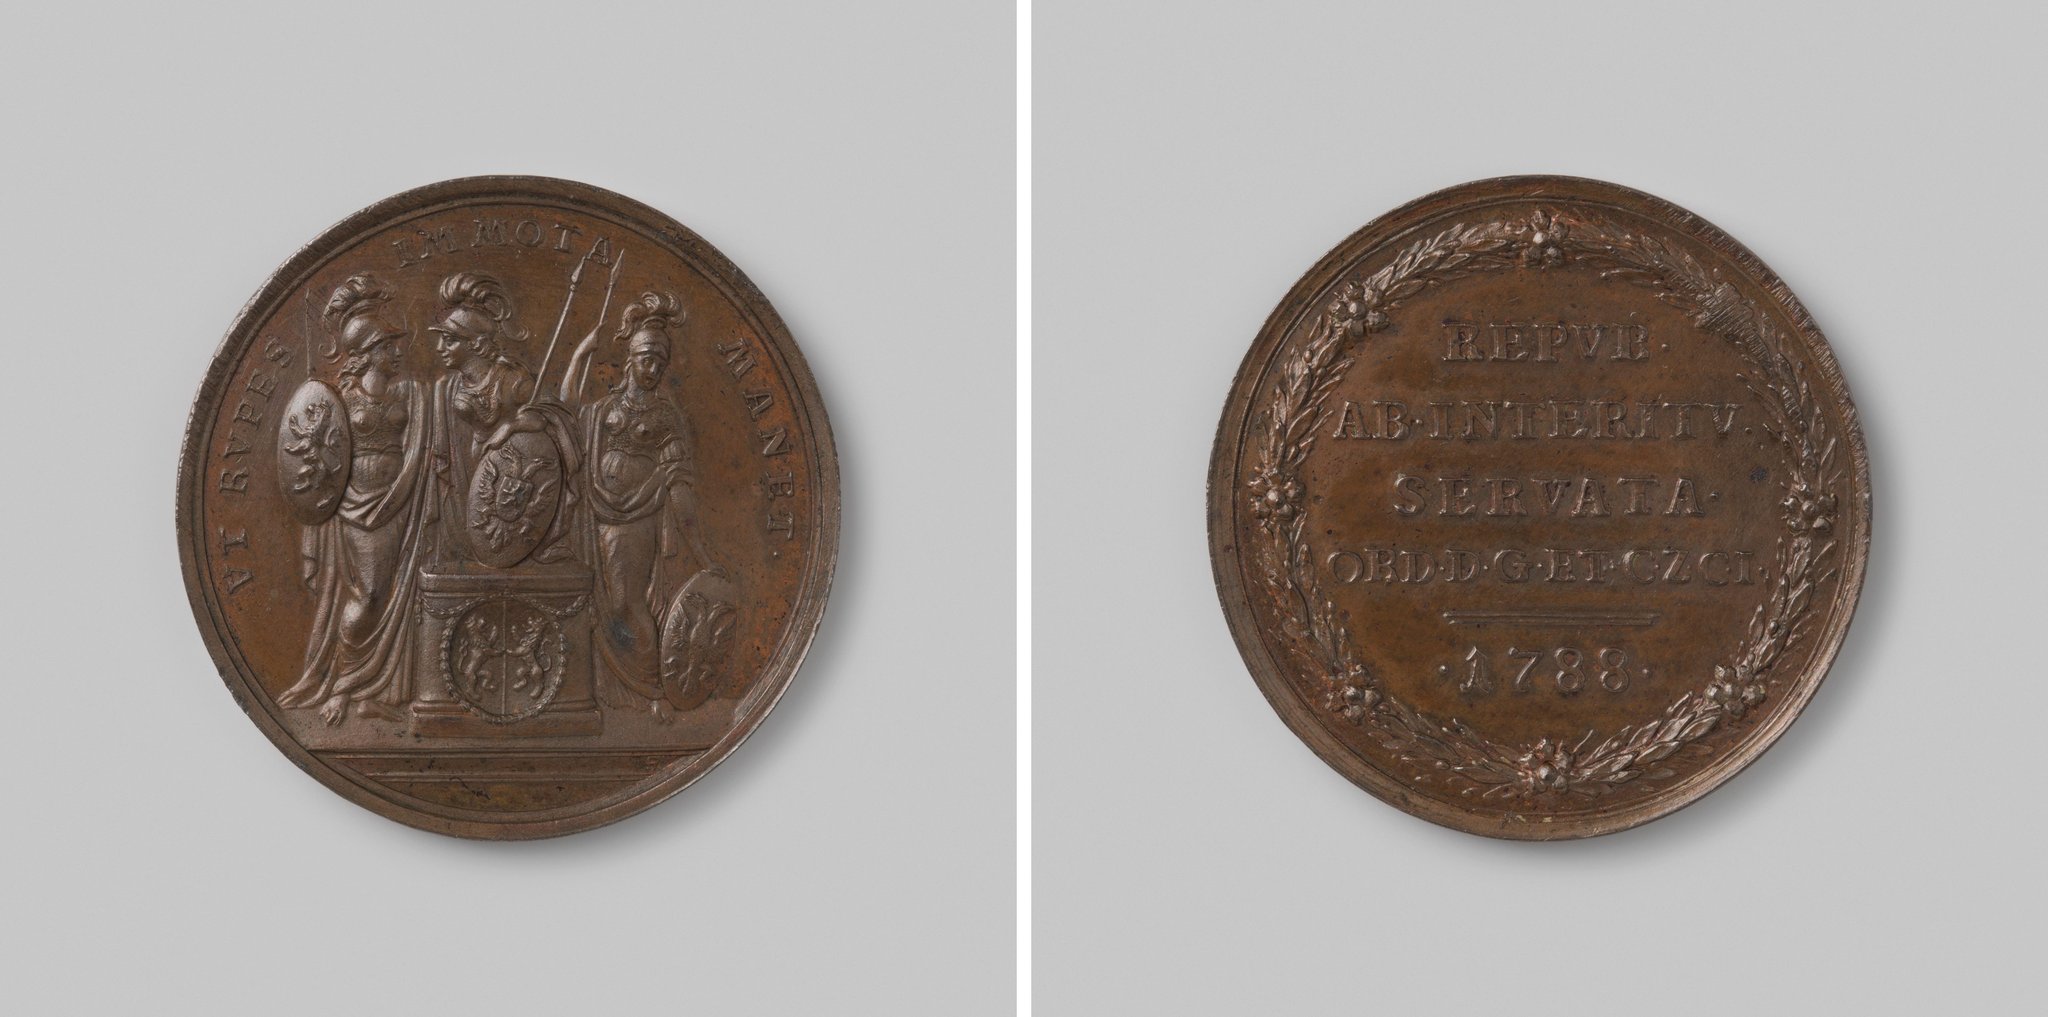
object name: history medal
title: Herstel van de orde in de Nederlanden 1788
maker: johann heinrich schepp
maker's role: sculptor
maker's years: 1736-1811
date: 1788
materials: bronze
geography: the hague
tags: nijmegen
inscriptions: circumscription: ‘VT RVPES IMMOTA MANET’, inscription: ‘REPVB. / AB . INTERITV . / SERVATA . / ORD.D.G.ET.C.Z.C.I. / 1788’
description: Bronzen penning. Voorzijde: 3 Romeinse vrouwen met schild en speer met omschrift. Keerzijde: lauwerkrans om opschrift.